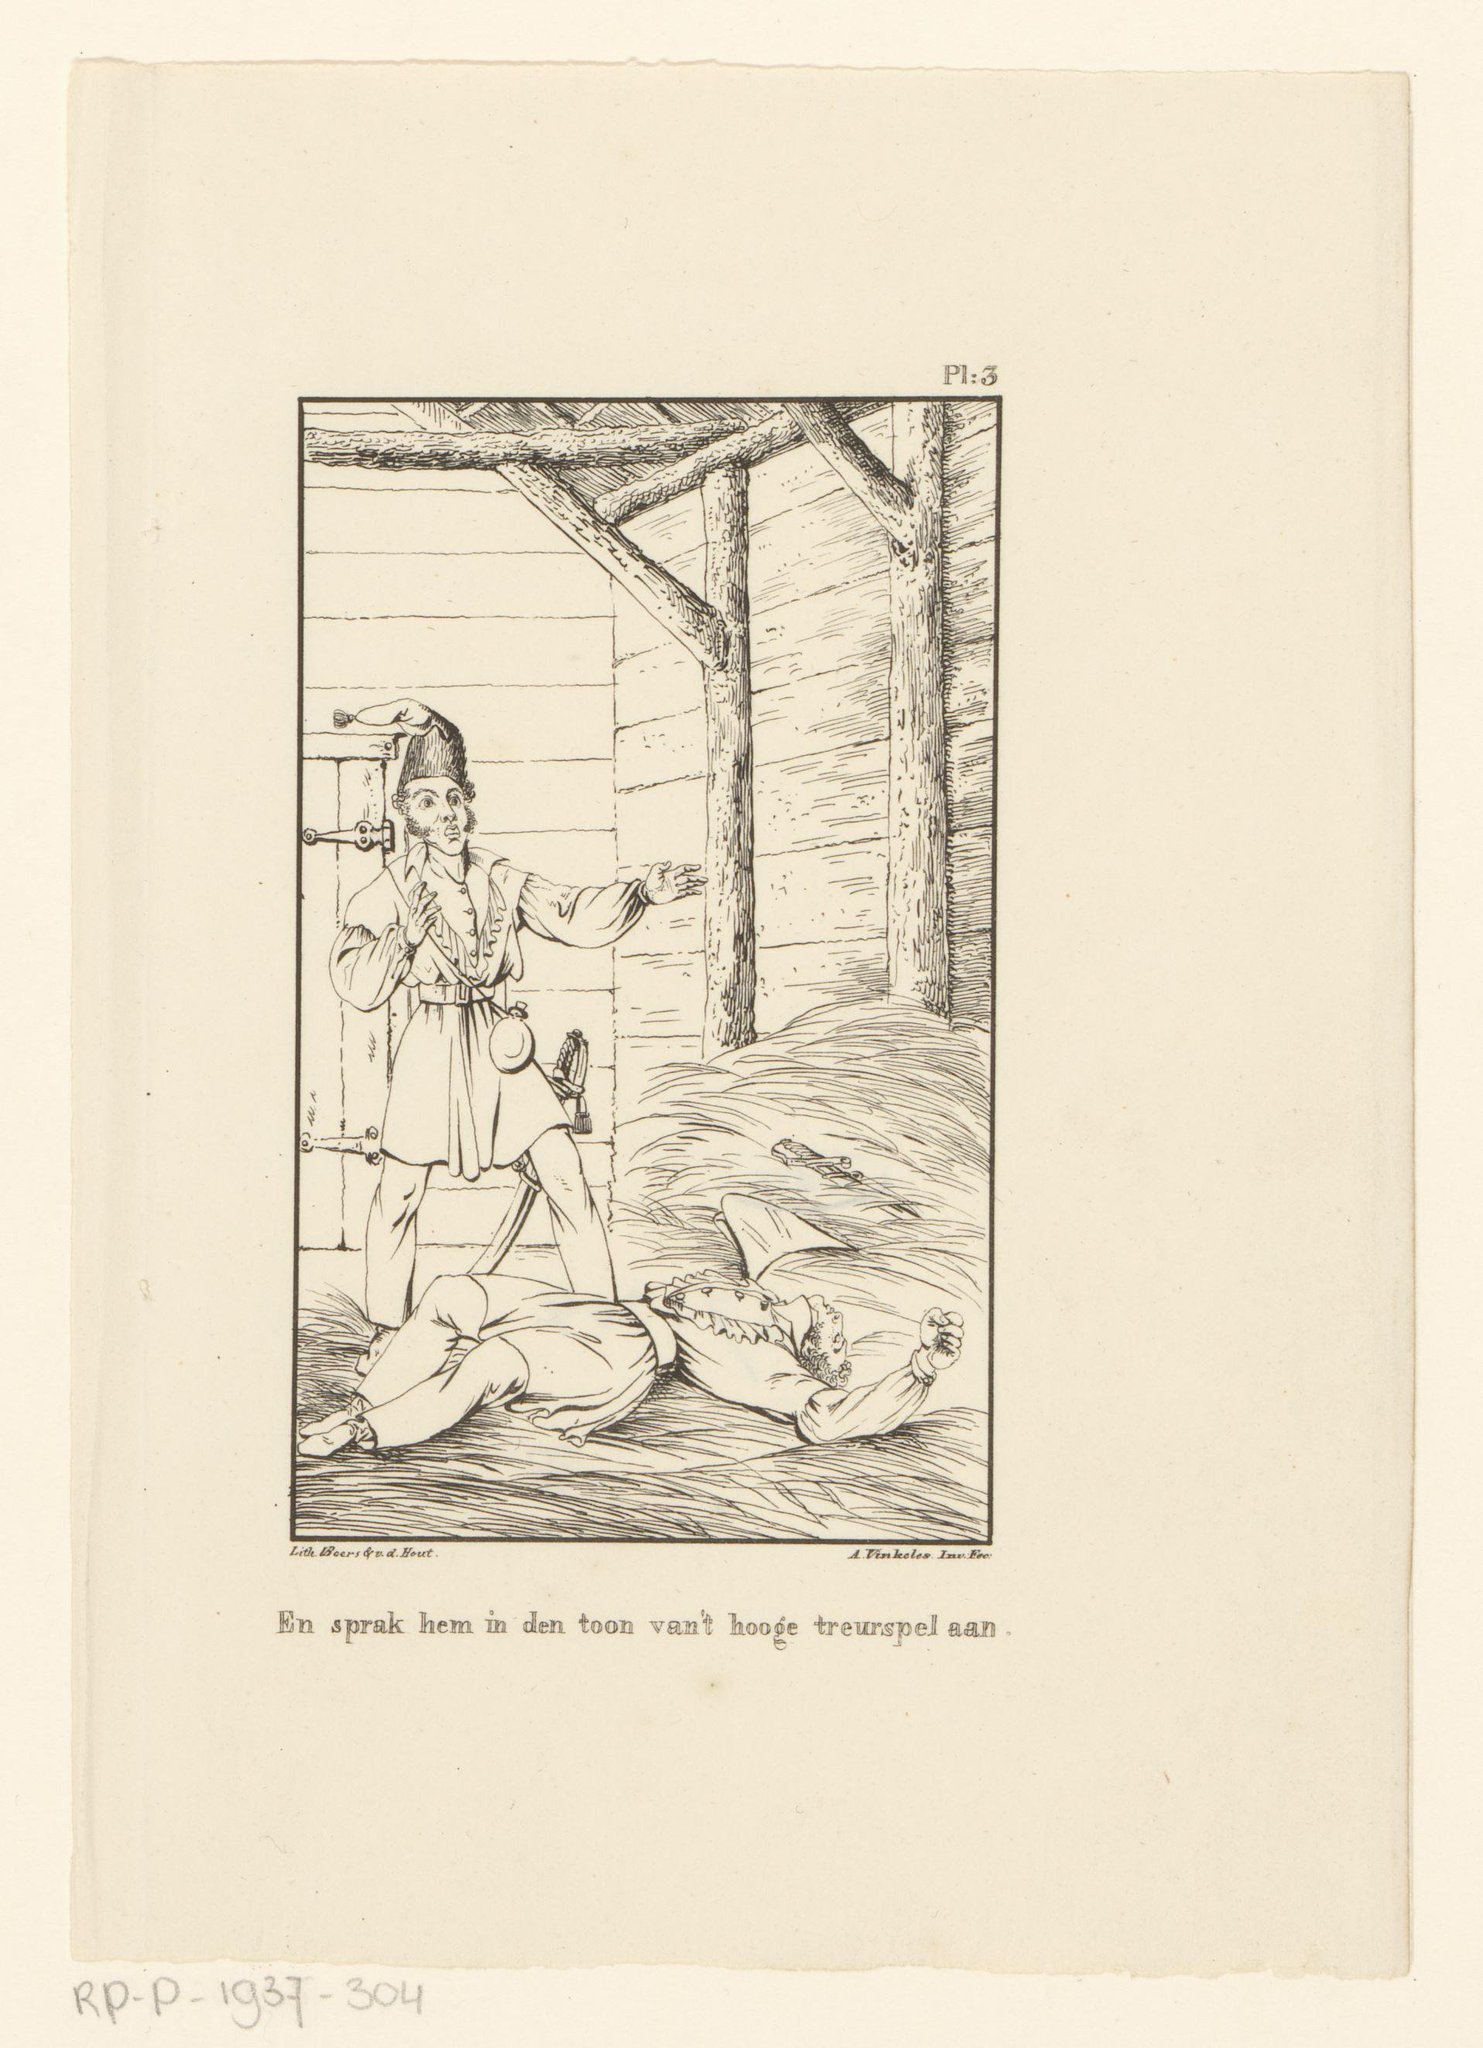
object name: cartoon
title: Tocht van de tachtig Luikenaren naar Tervuren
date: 1832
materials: paper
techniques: lithograph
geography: rotterdam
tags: fainting, swooning, liège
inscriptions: collector's mark: Lugt 2228, collector's mark: Lugt 2760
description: De leider van de groep Luikenaren valt verslagen in het stro als het Nederlandse leger Leuven binnen trekt. Spotprent als illustratie in een heldenzang over de tocht van de tachtig Luikenaren naar Tervuren op 6 september 1830. Rechtsboven genummerd Pl. 3.